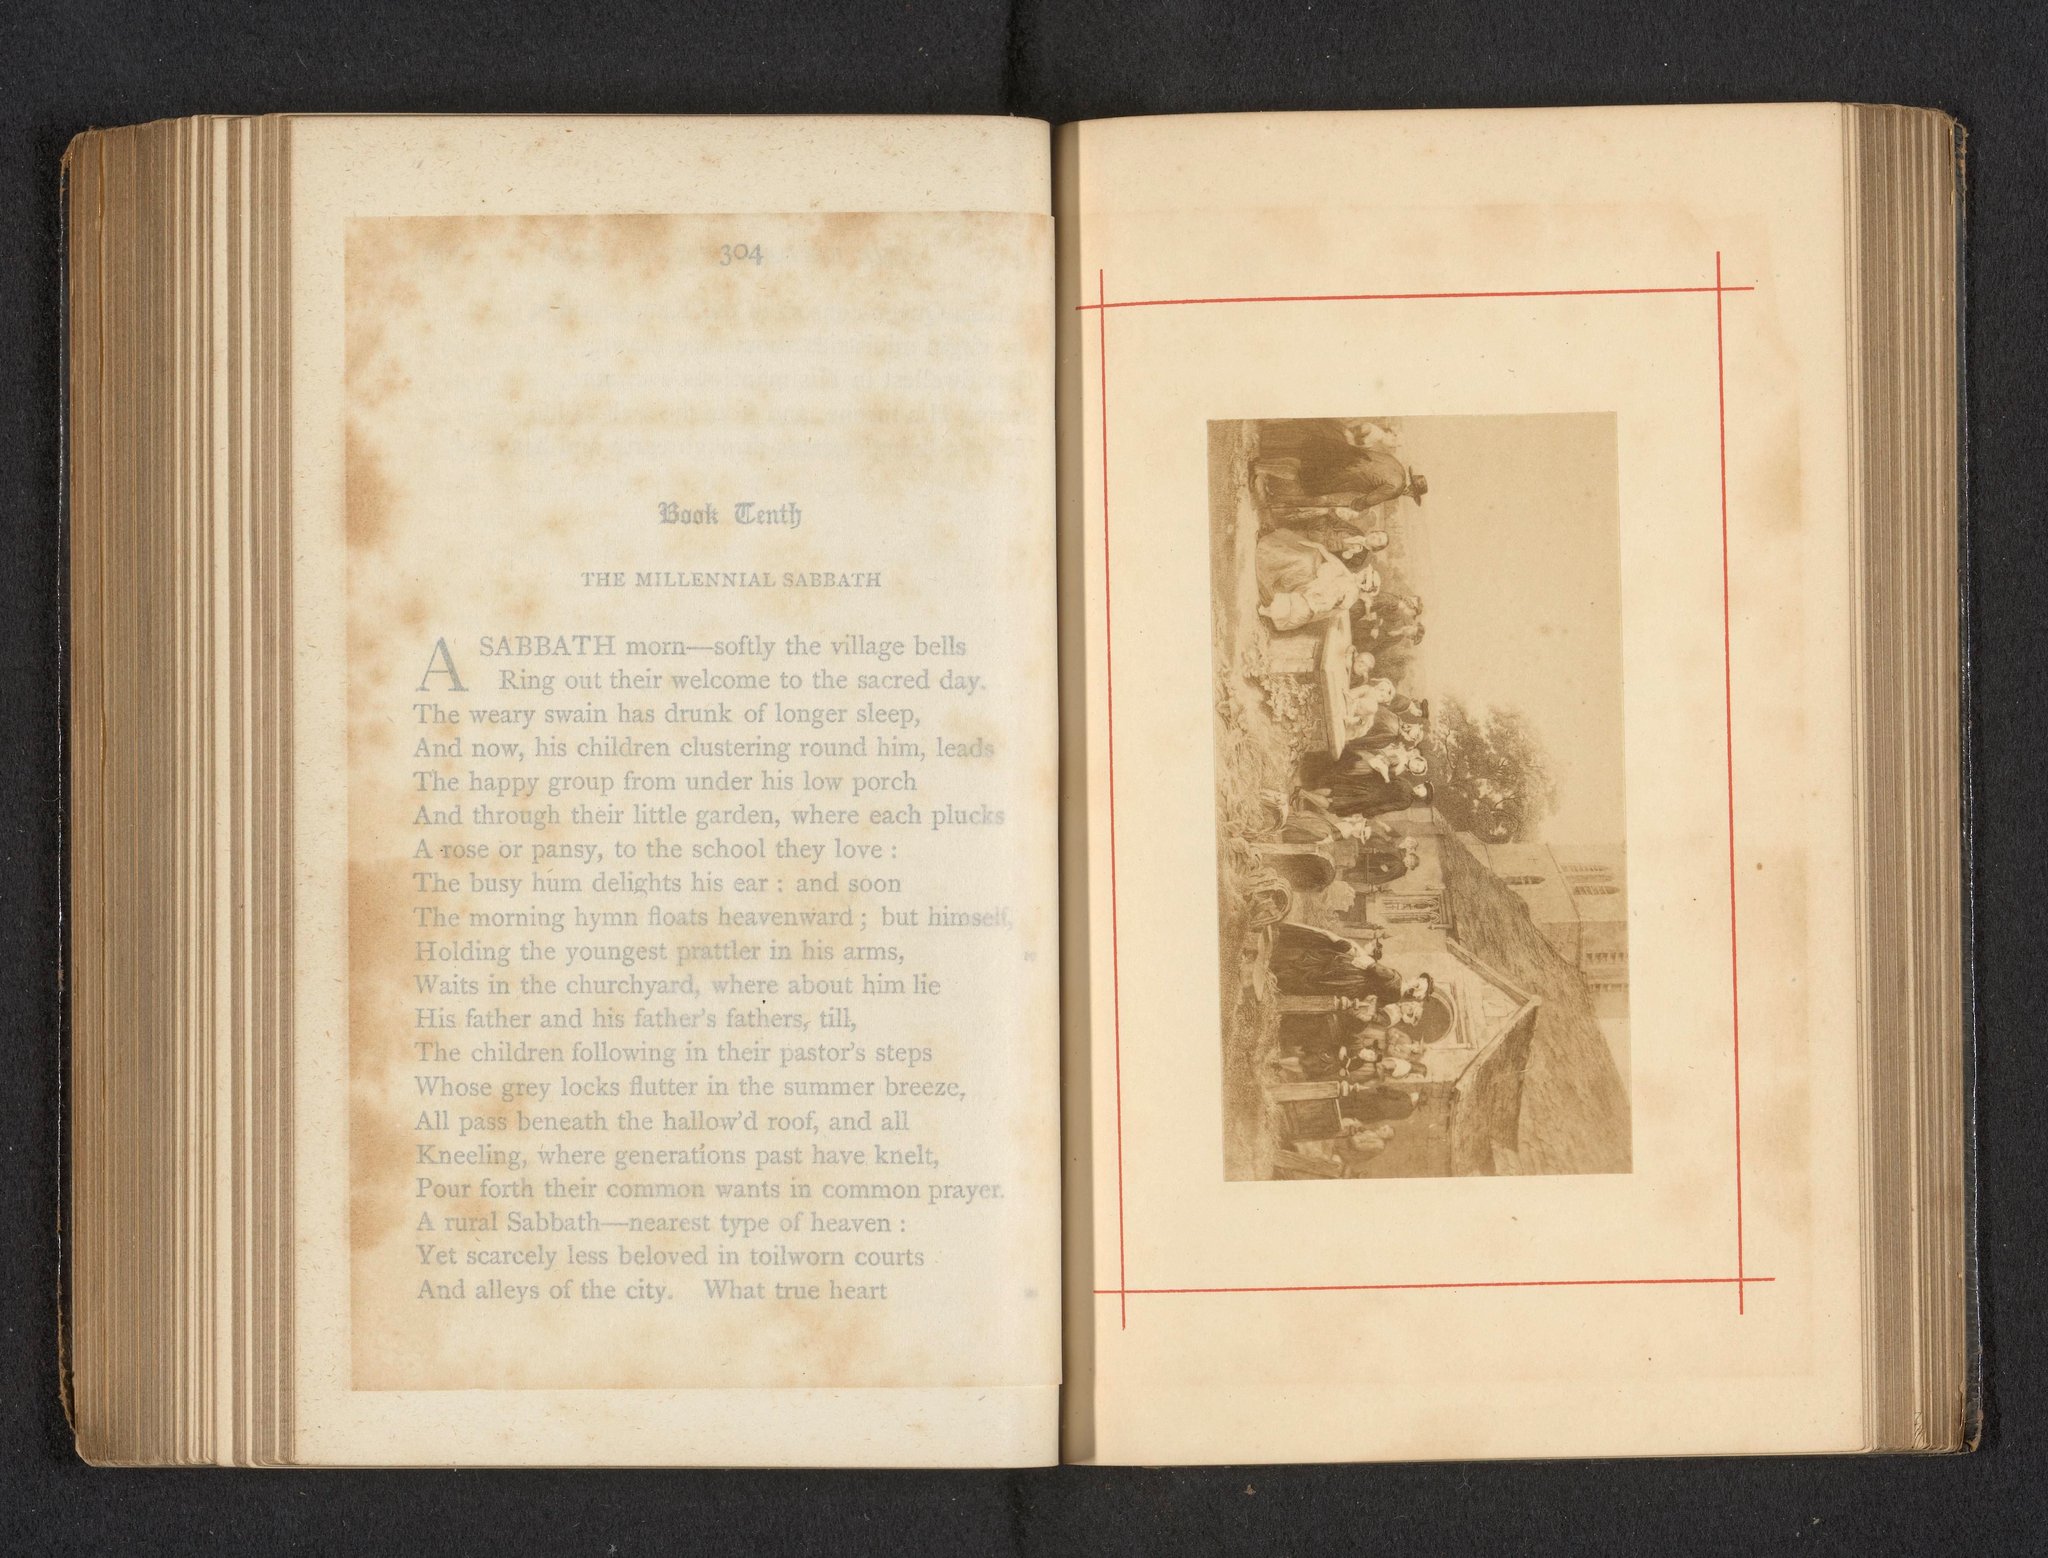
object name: page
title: Fotoreproductie van een schilderij, voorstellende een samenkomst van mensen op een kerkhof tijdens de Sabbat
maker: Anonymous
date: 1868-1878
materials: photographic support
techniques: albumen print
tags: church (exterior), churchyard, cemetery